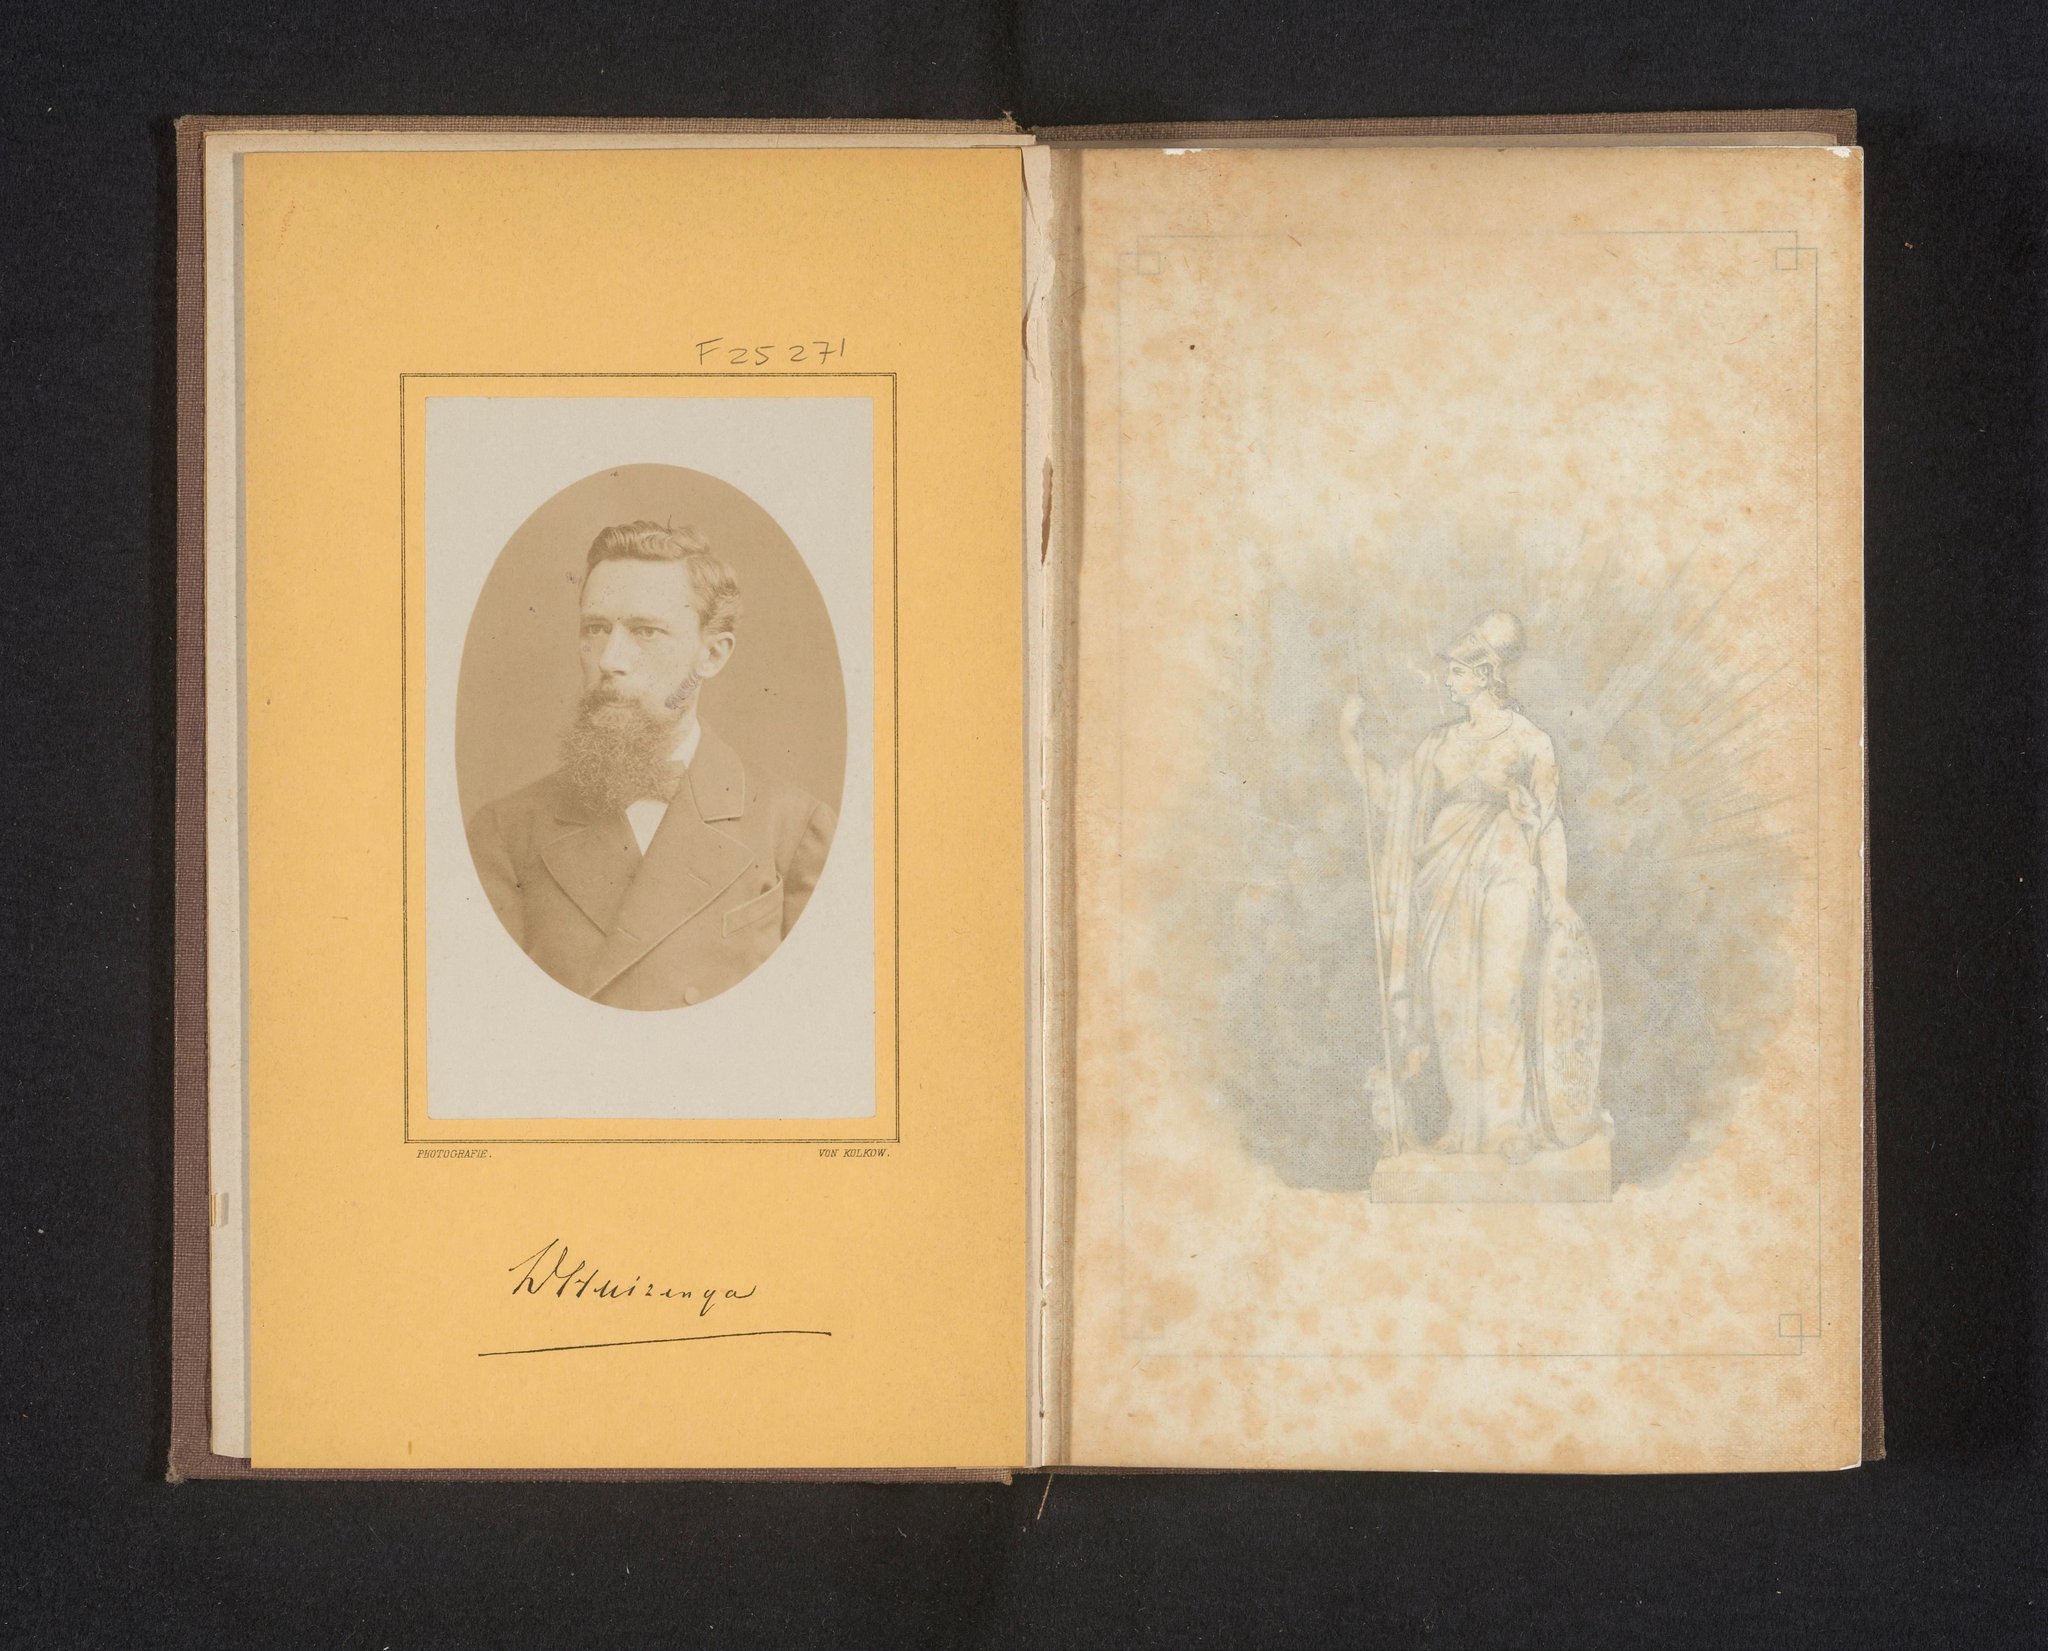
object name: photograph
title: Portret van Dirk Huizinga, hoogleraar geneeskunde in Groningen en rector magnificus van 1879 tot 1880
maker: friedrich julius von kolkow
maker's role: fotograaf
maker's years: 1839-1914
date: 1875-1880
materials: photographic support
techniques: albumen print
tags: historical persons, professor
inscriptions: name: ‘D Huizinga’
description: Foto op derde ongenummerde pagina voor titelpagina.